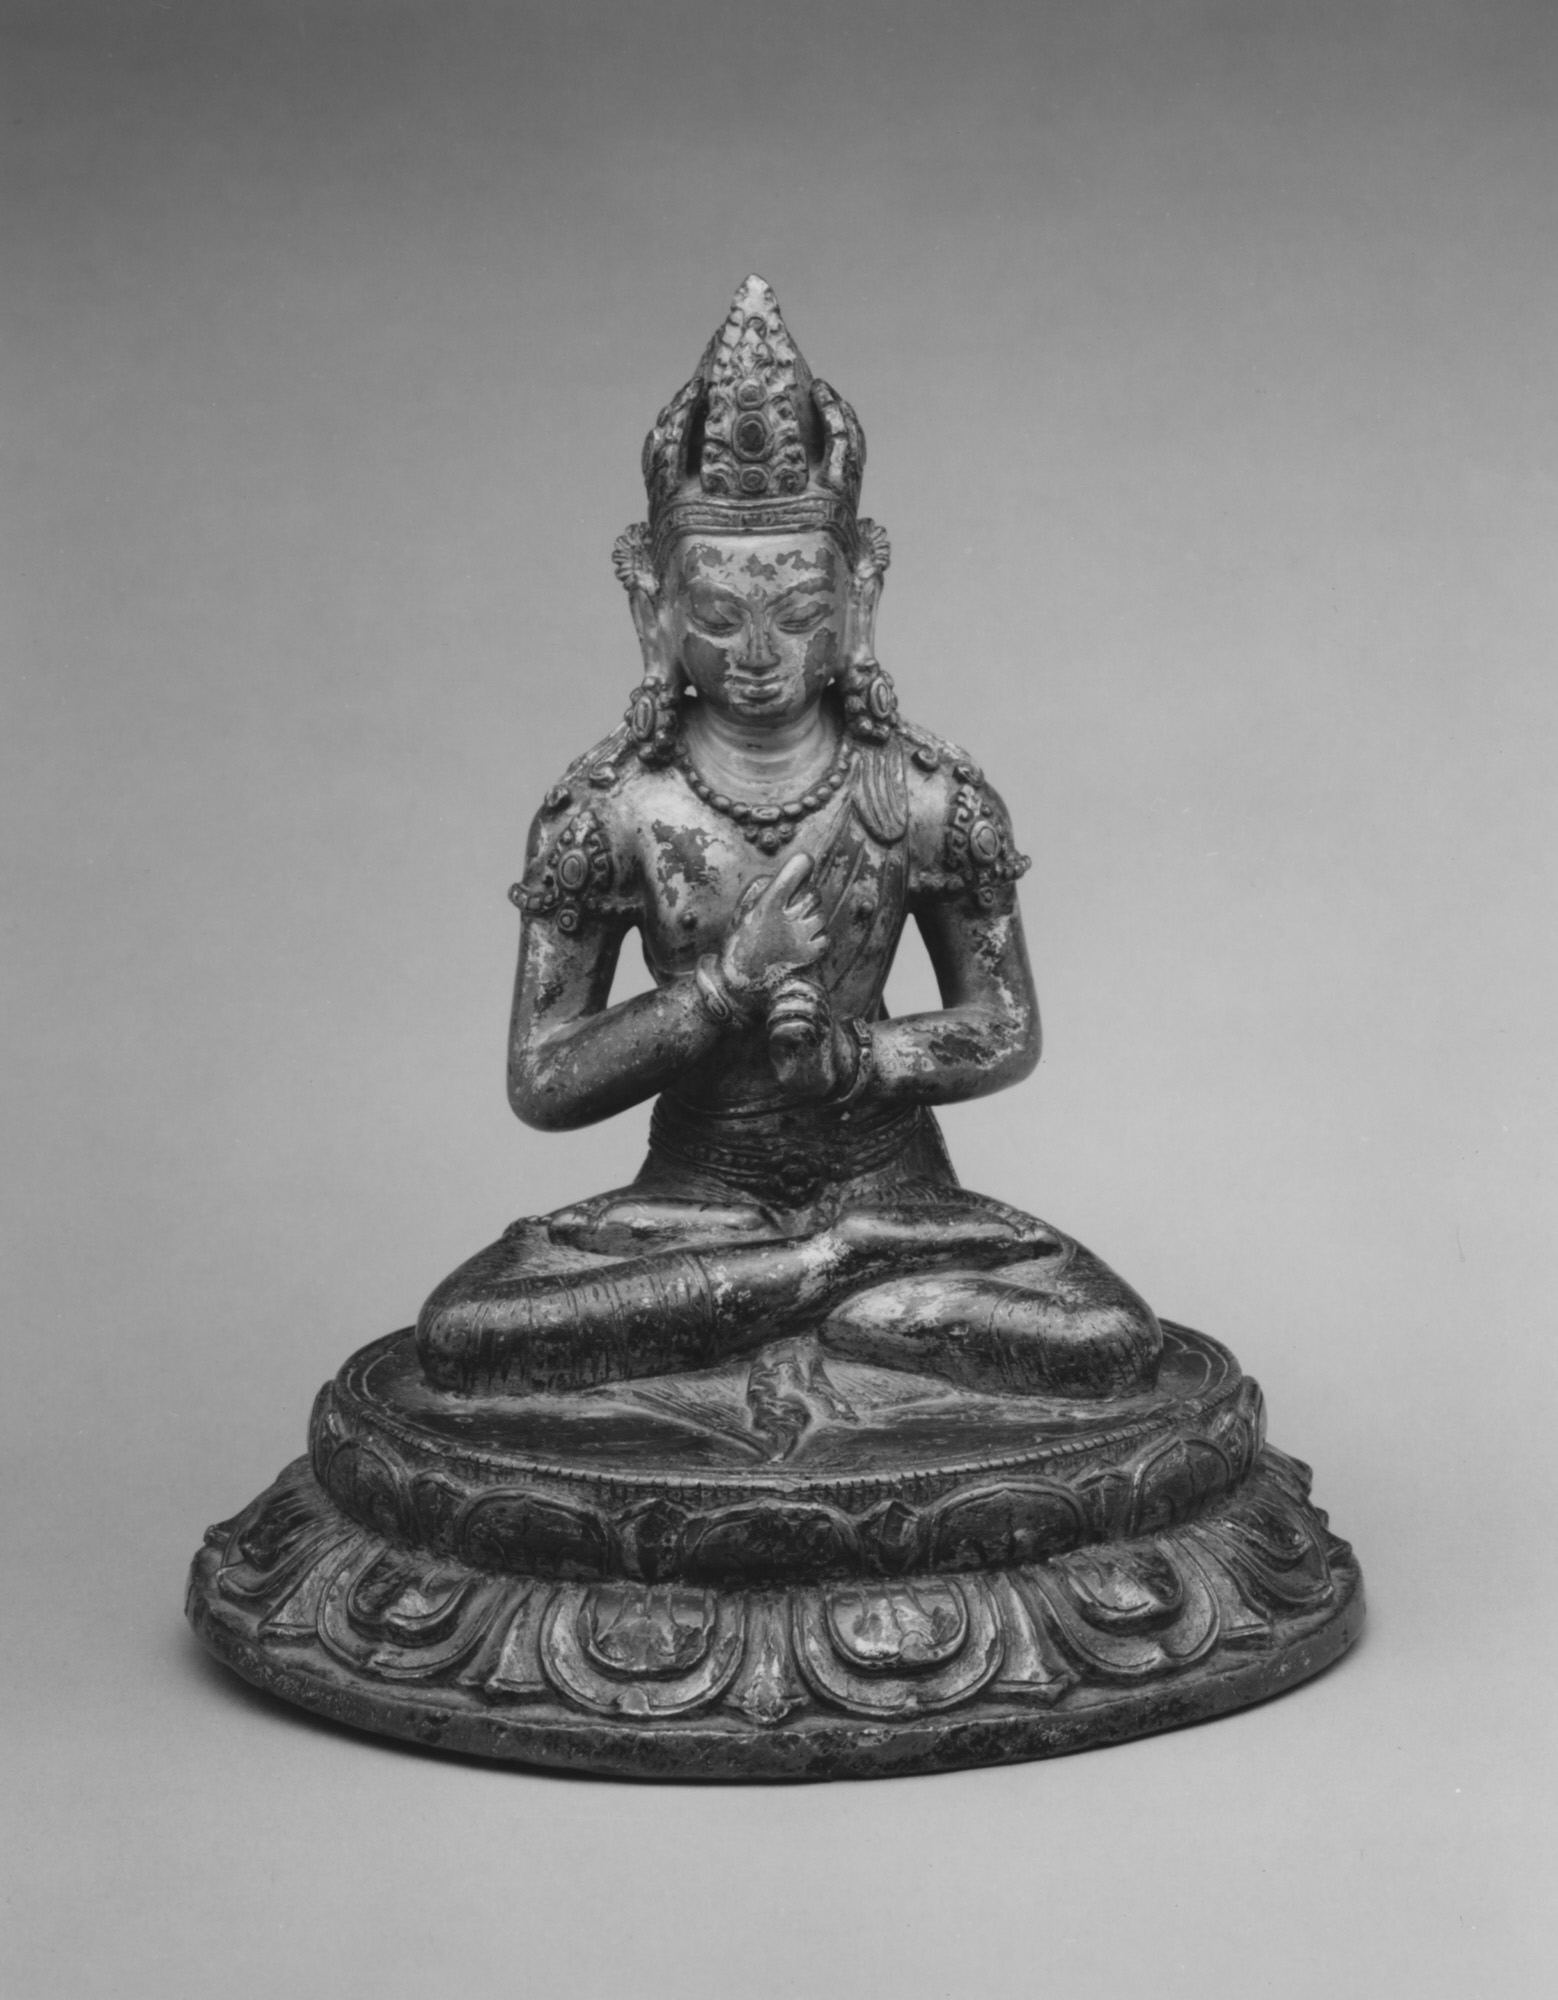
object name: figure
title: Vairochana, the Supreme Transcendent Buddha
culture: nepali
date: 1001-1200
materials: copper alloy, gilt, gold paint, pigment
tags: buddhism,buddha